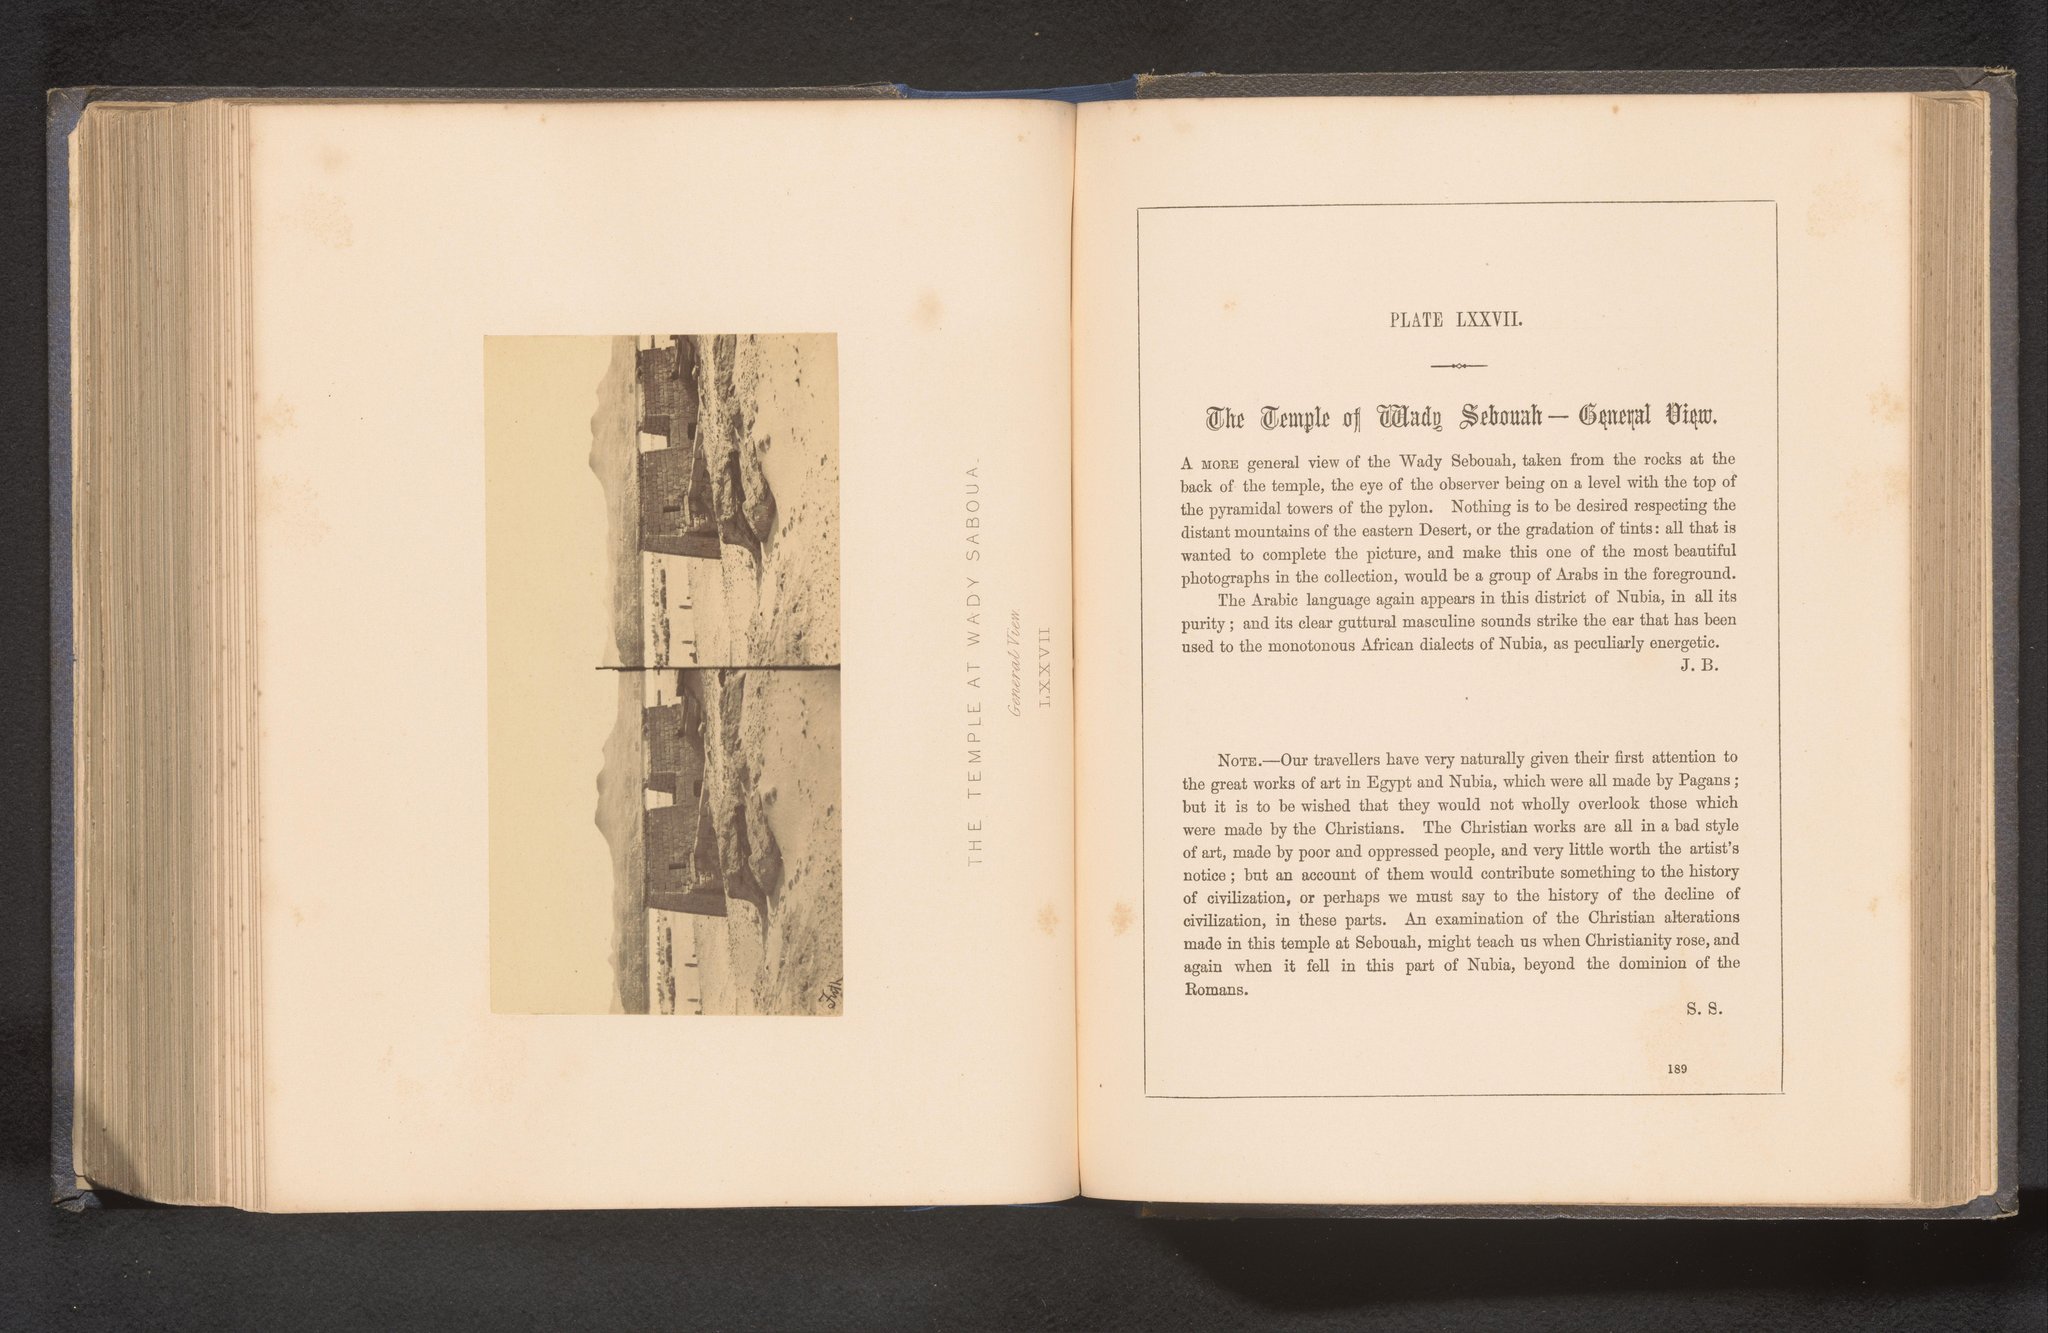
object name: stereograph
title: Gezicht op de tempel voor Amon door Ramses II bij Wadi es-Sebua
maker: francis frith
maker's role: publisher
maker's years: 1822-1898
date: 1857-1862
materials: photographic support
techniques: albumen print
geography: egypt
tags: city-view, and landscape with man-made constructions, temple, shrine ~ egyptian religion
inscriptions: name: ‘Frith’, inscription: ‘General View’, number: ‘LXXVII’